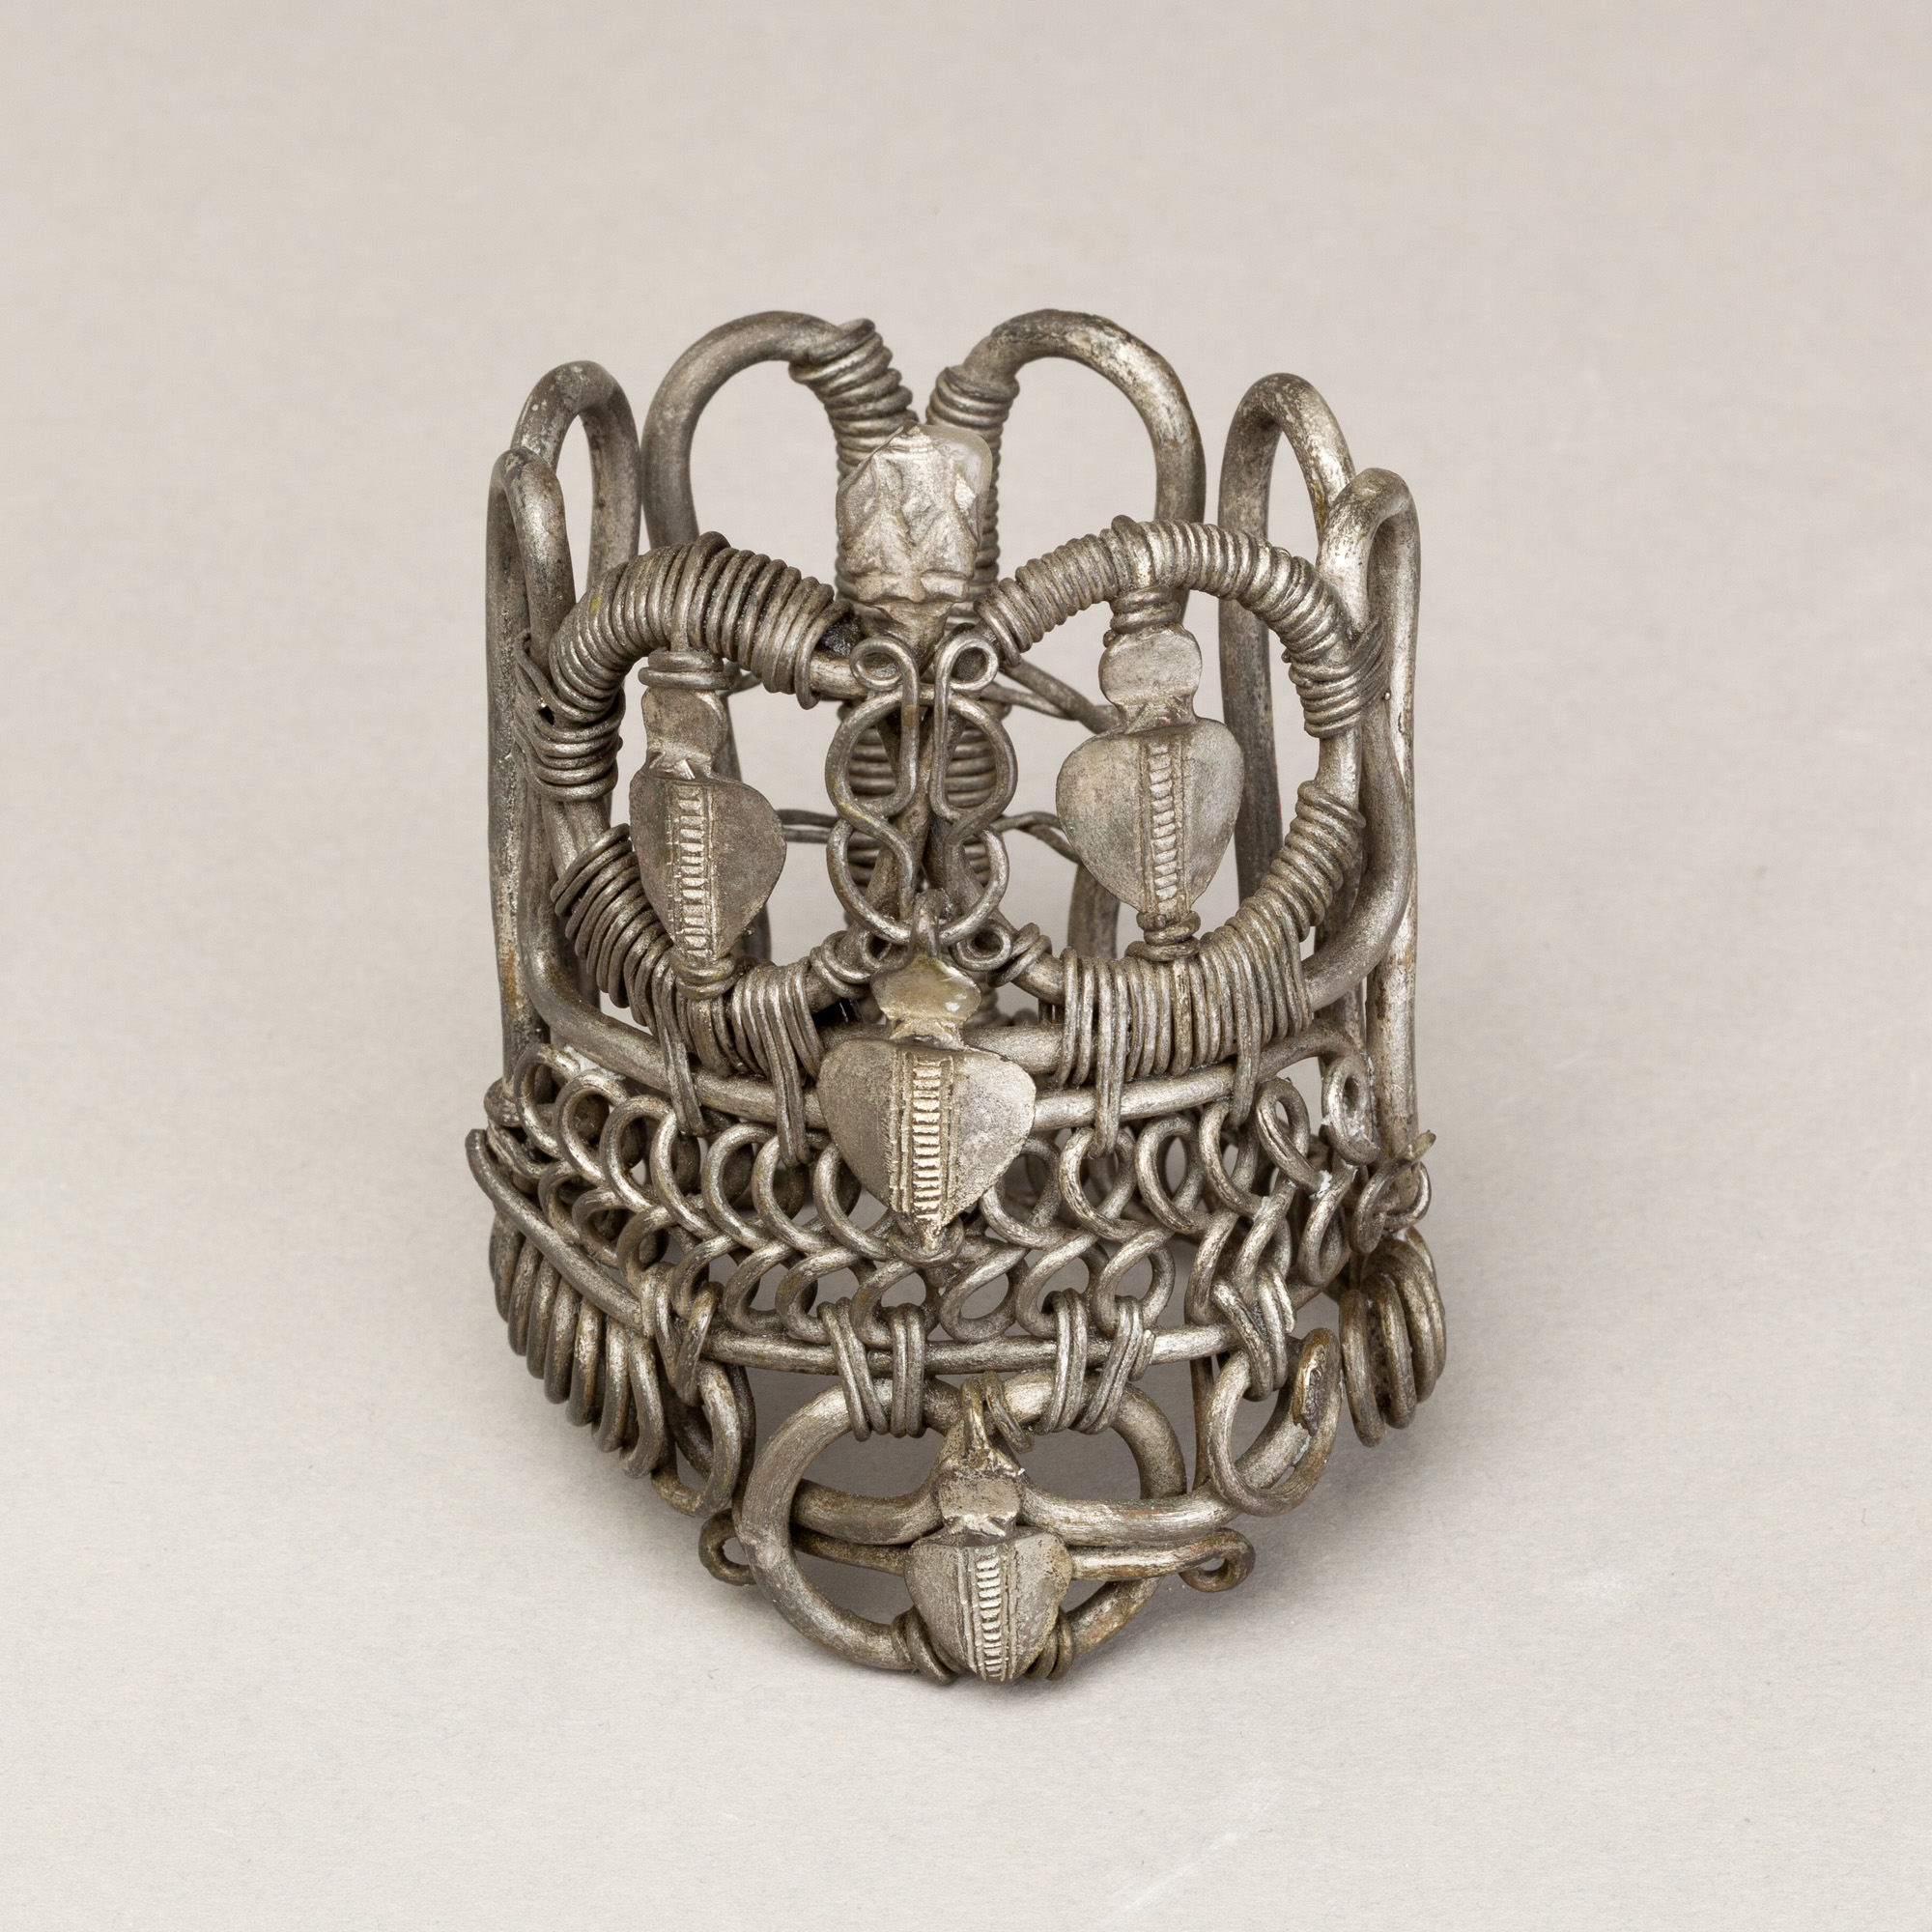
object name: bracelet or armlet, uraei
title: Bracelet or armlet with uraei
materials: silver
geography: egypt